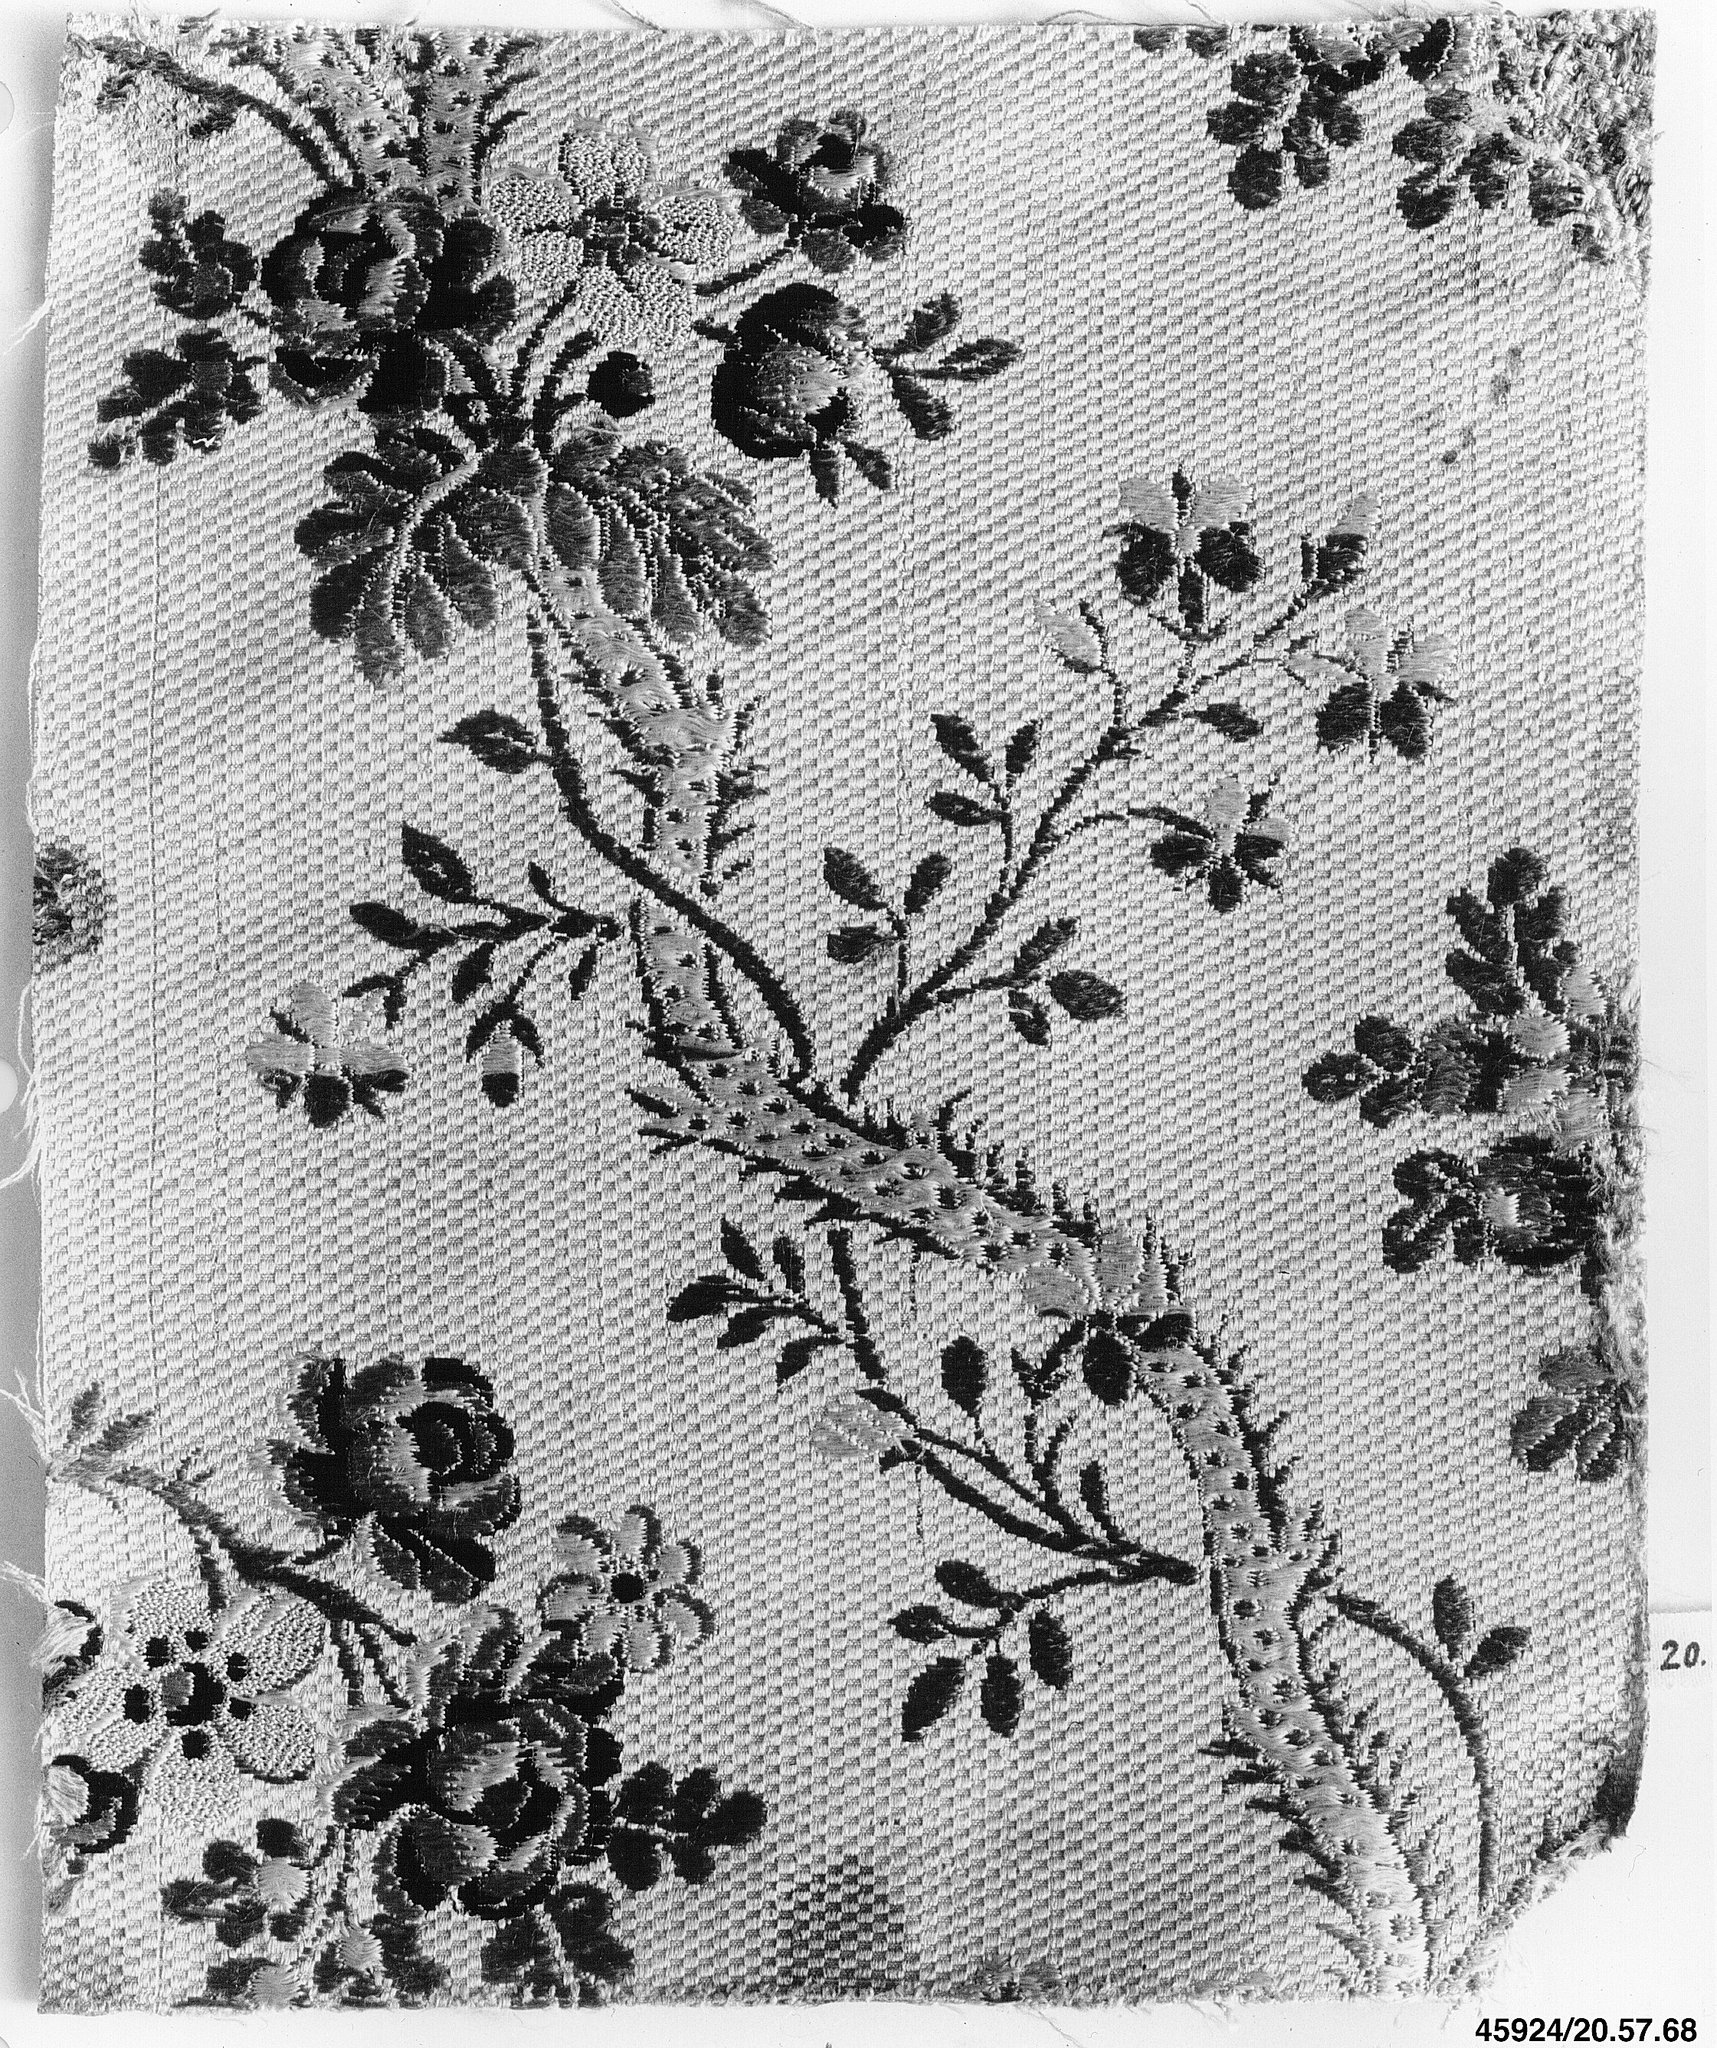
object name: piece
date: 1750-1760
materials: silk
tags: flowers,leaves